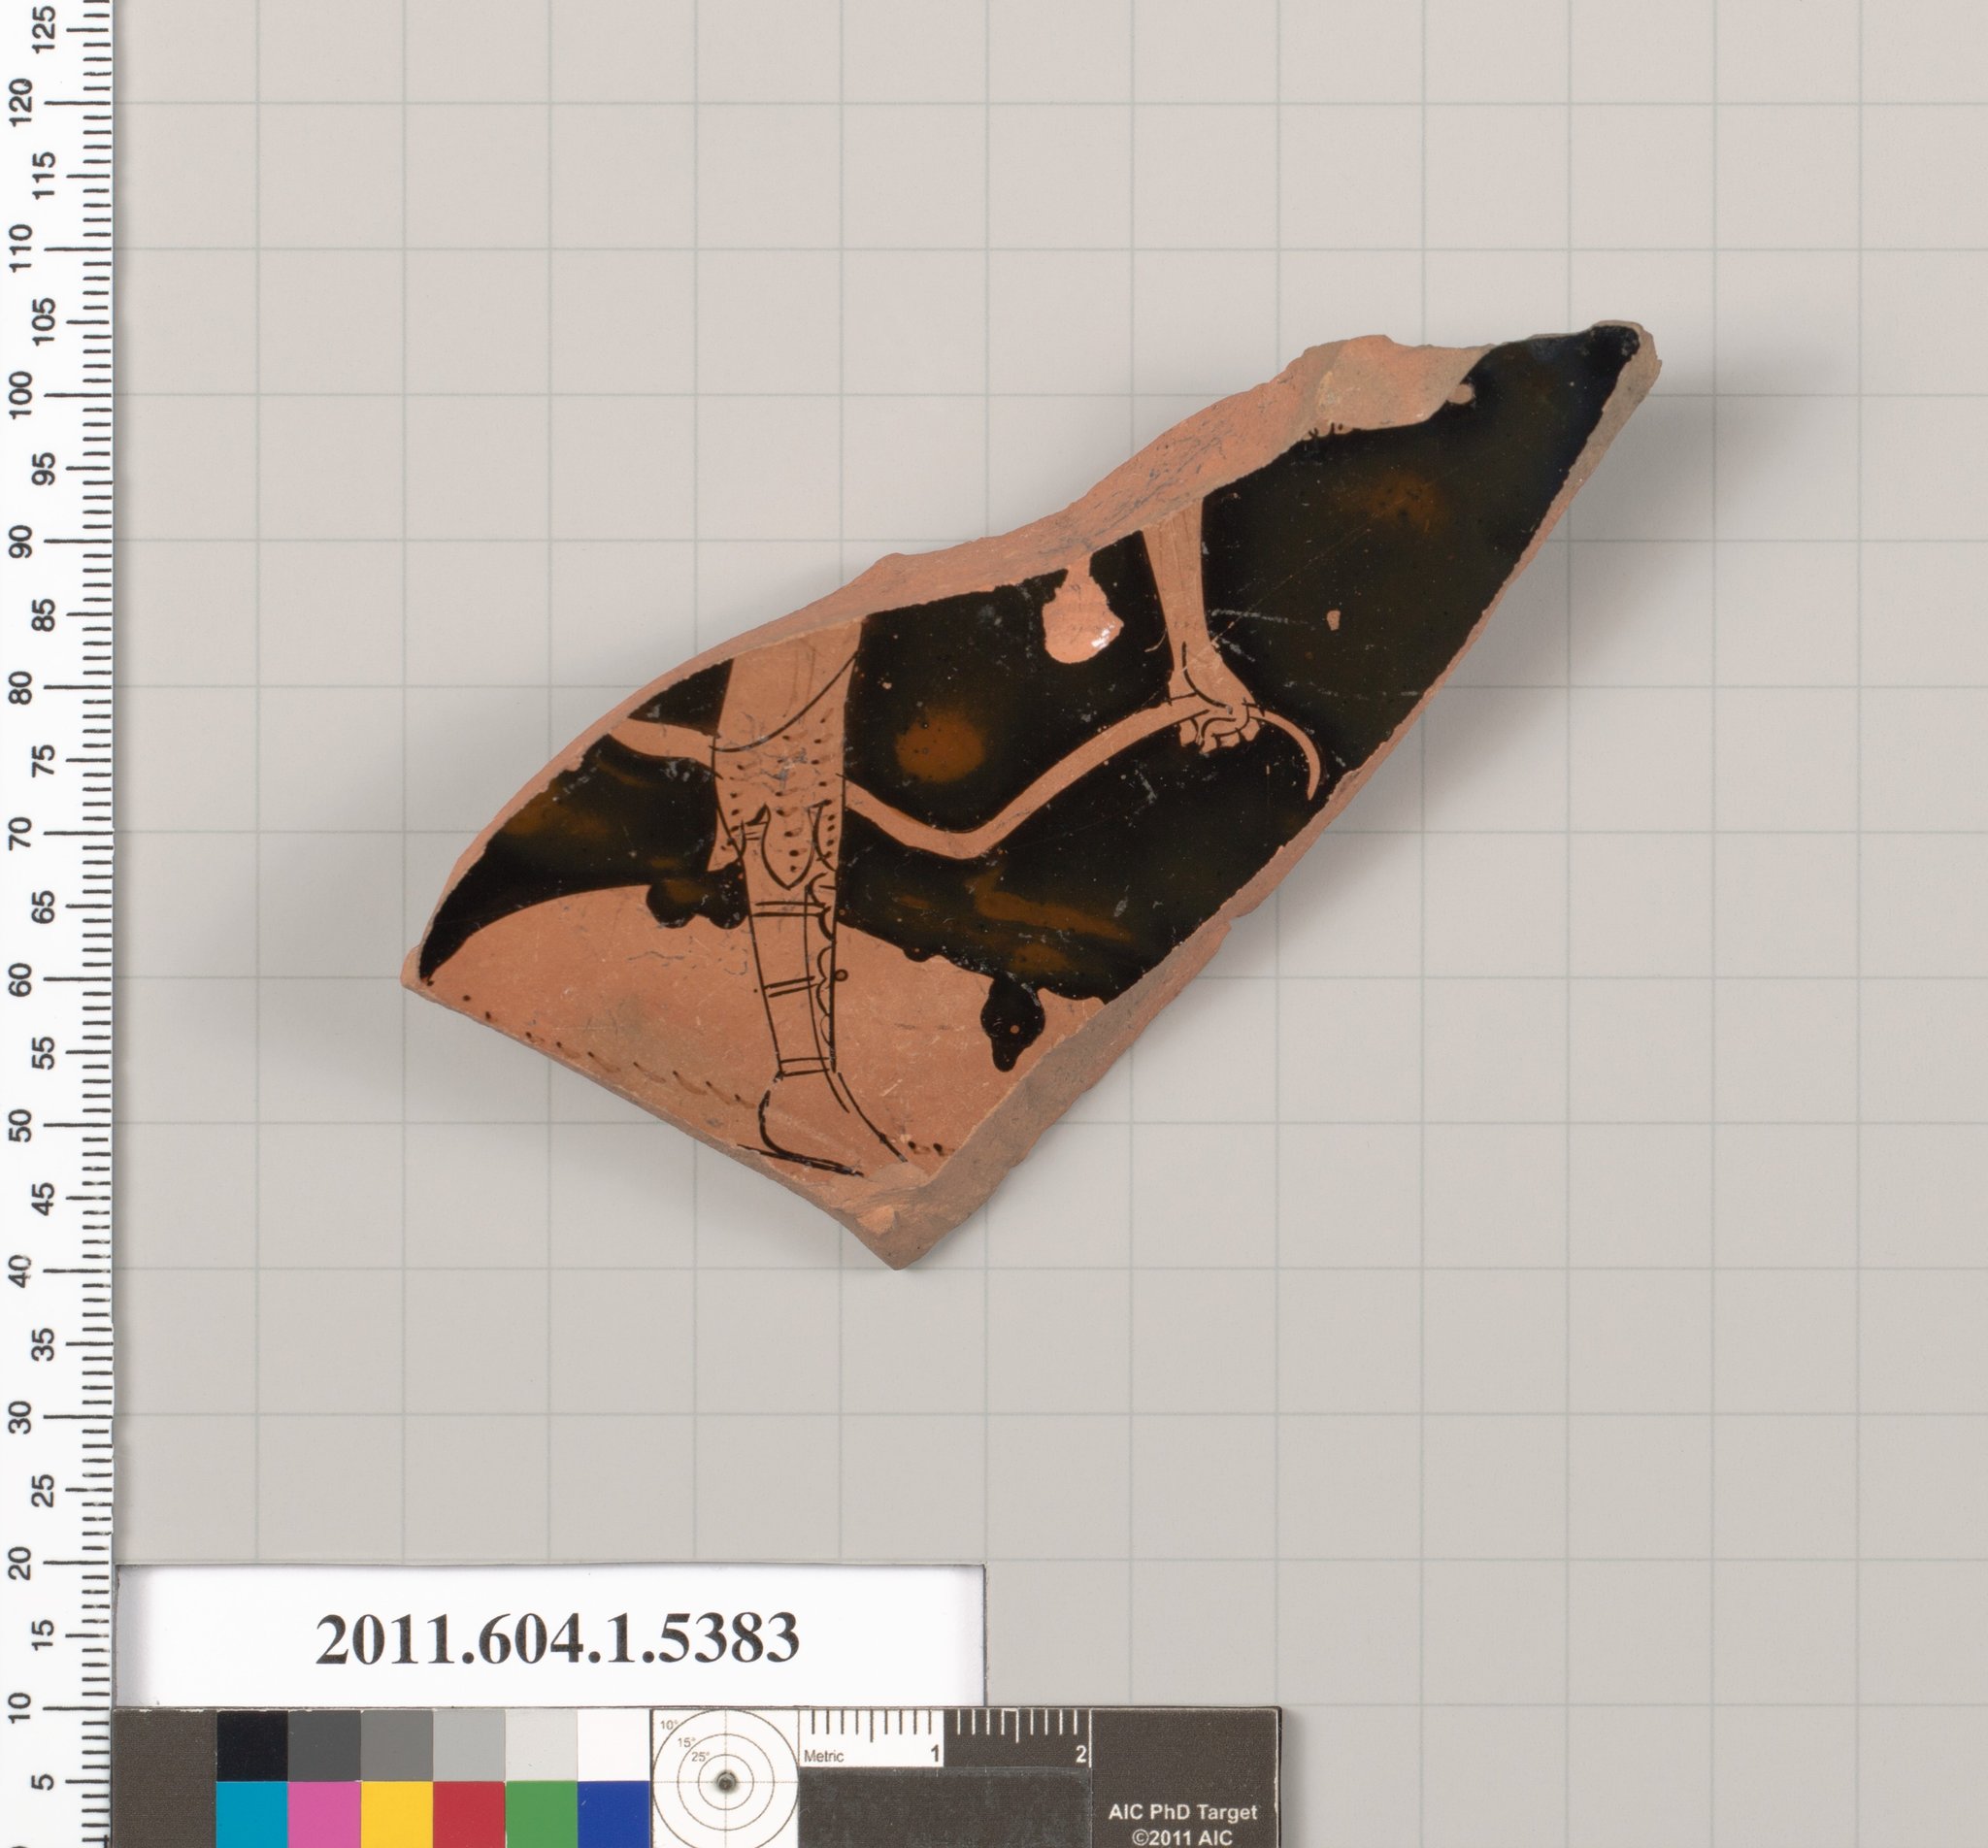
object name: kylix fragment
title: Terracotta fragment of a kylix (drinking cup)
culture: greek, attic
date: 500-490 BCE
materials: terracotta